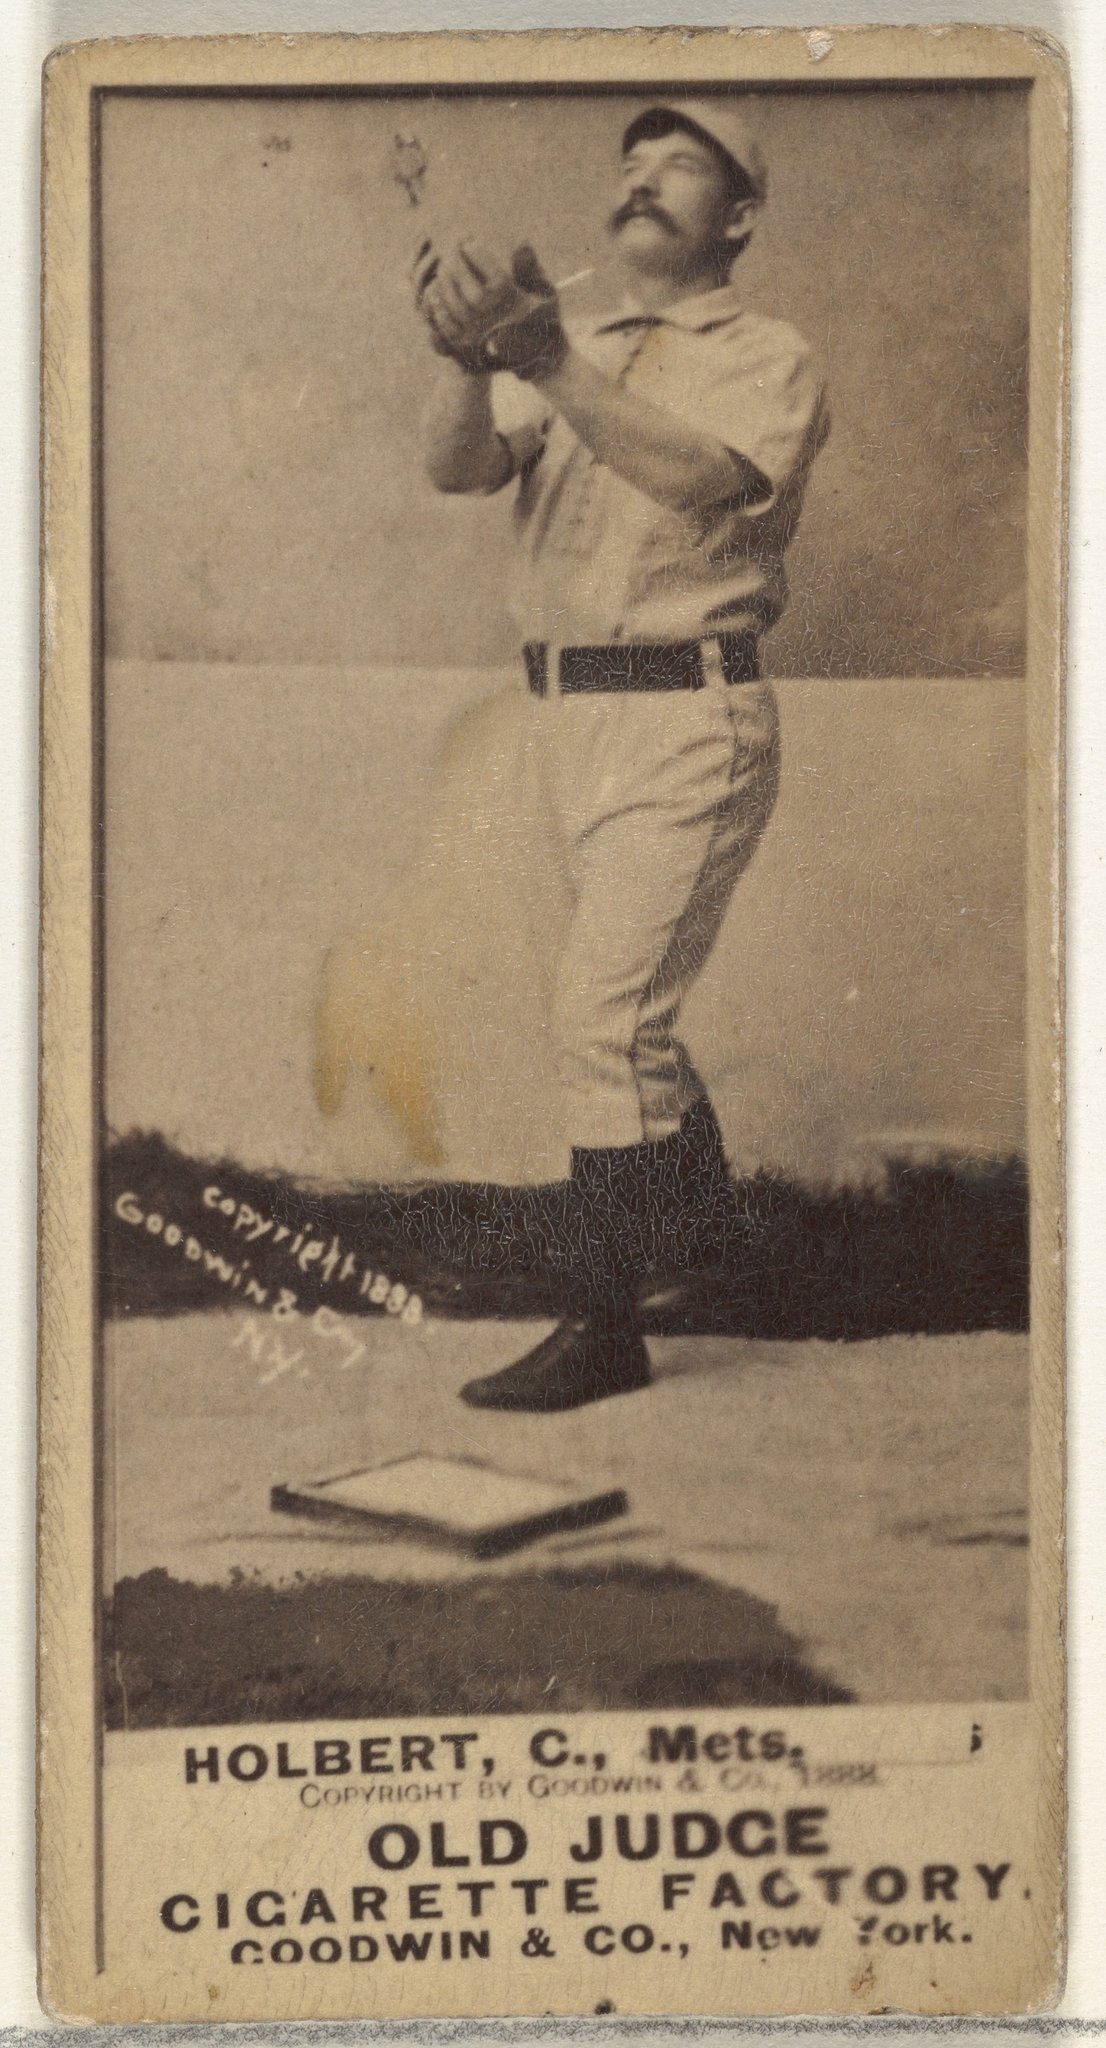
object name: baseball card, photograph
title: William Henry "Bill" Holbert, Catcher, New York Metropolitans, from the Old Judge series (N172) for Old Judge Cigarettes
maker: goodwin & company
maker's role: publisher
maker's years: 1850-1950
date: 1888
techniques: albumen silver print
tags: men,portraits,baseball,athletes